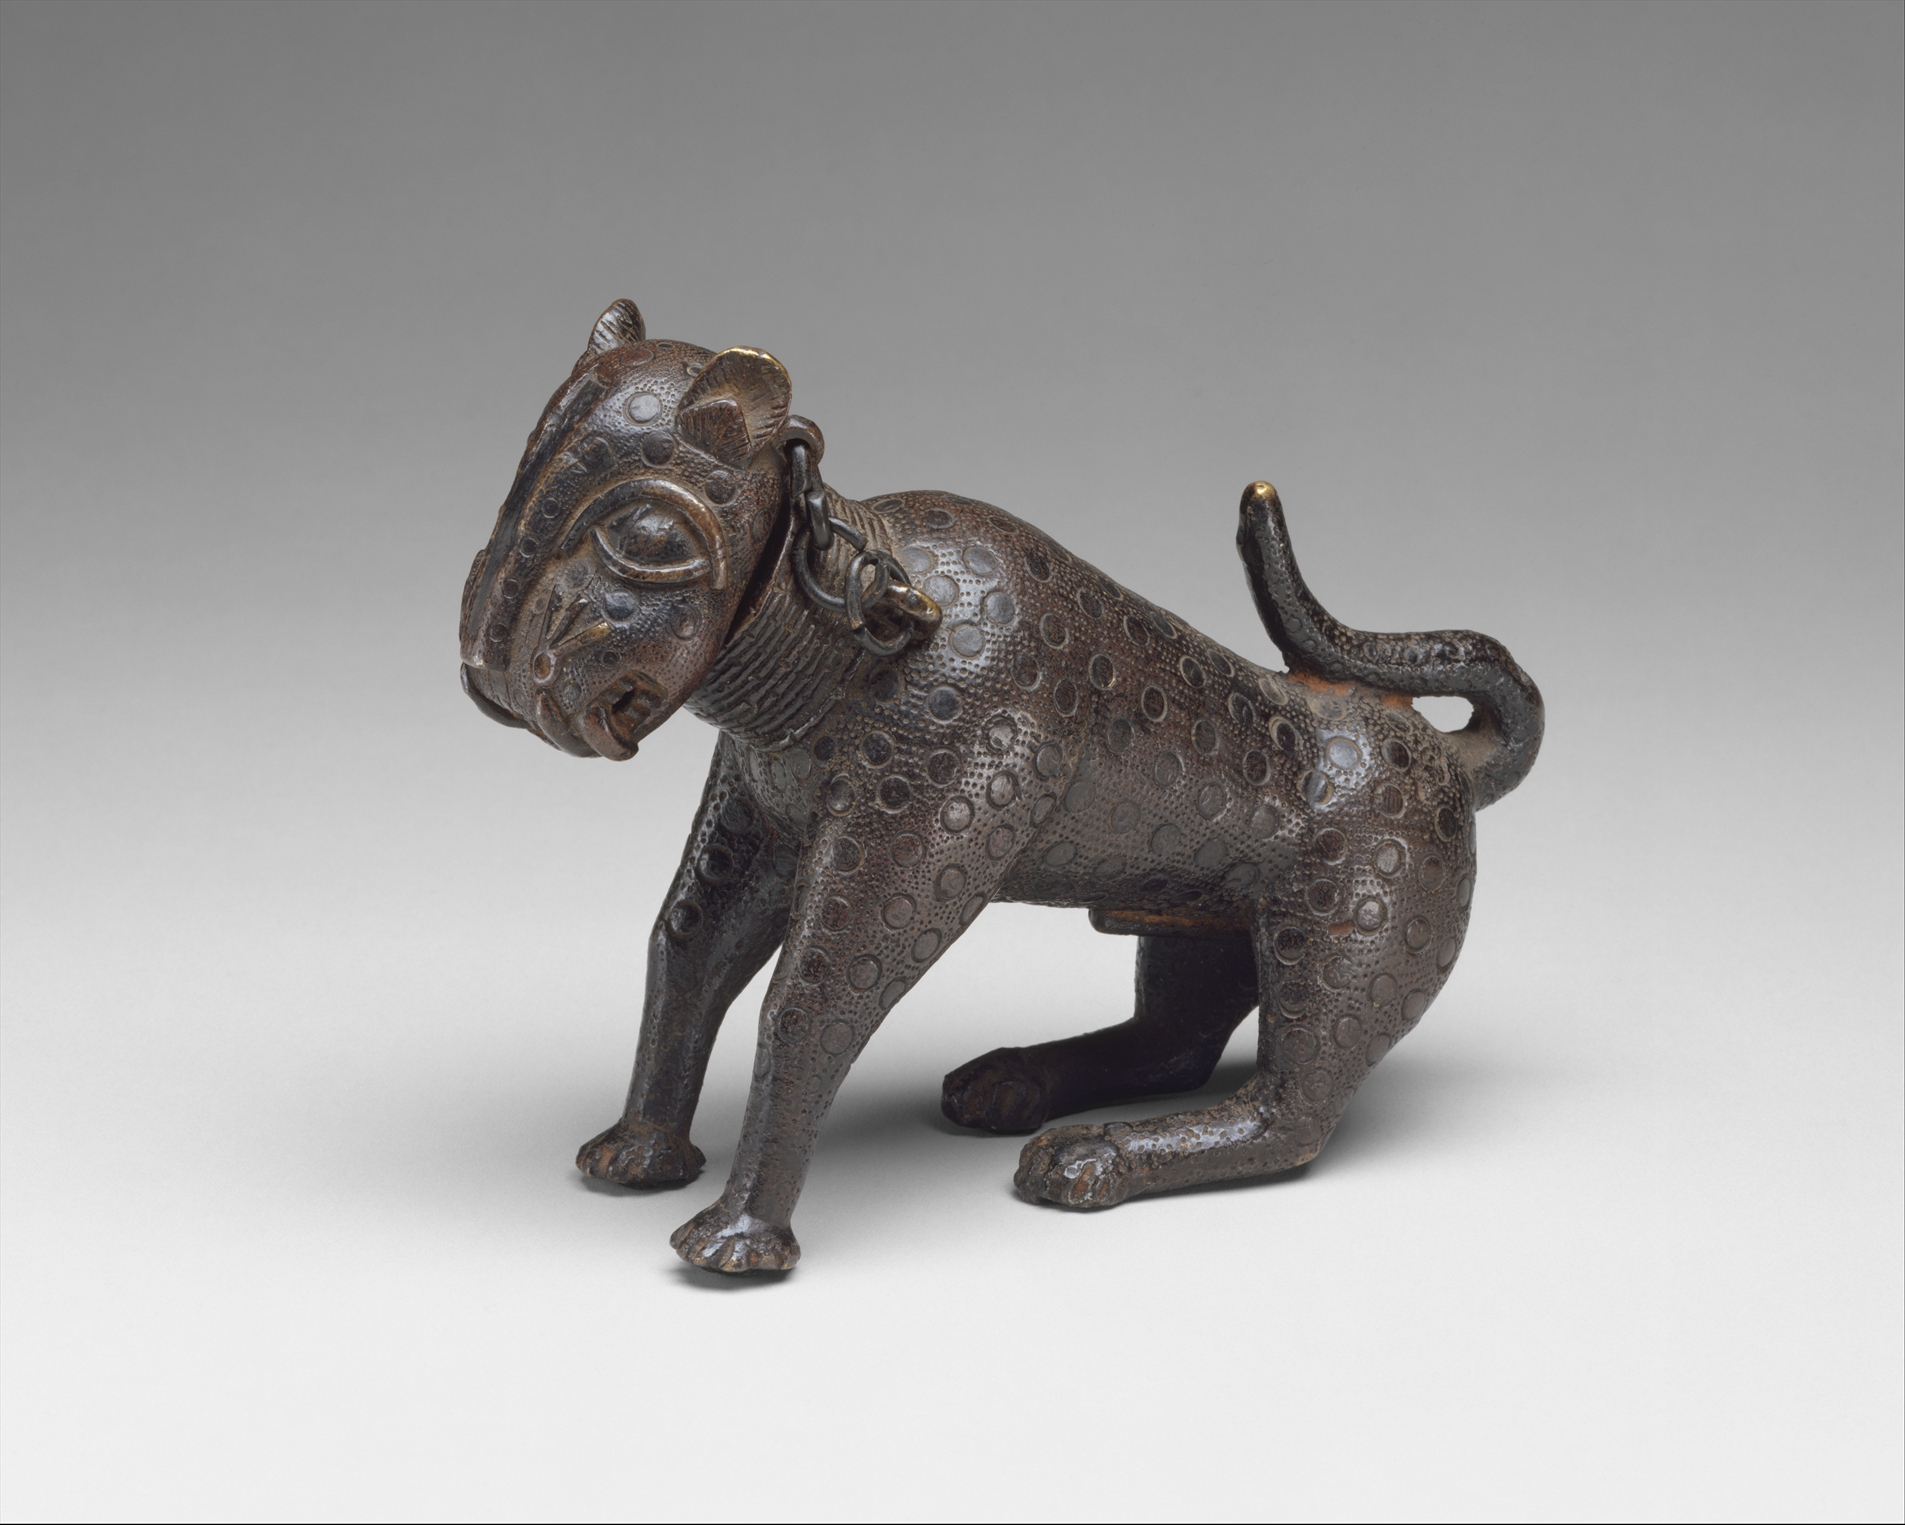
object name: aquamanile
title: Leopard Aquamanile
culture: edo period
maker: edo artist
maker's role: artist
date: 1501-1900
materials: brass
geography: nigeria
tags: leopards